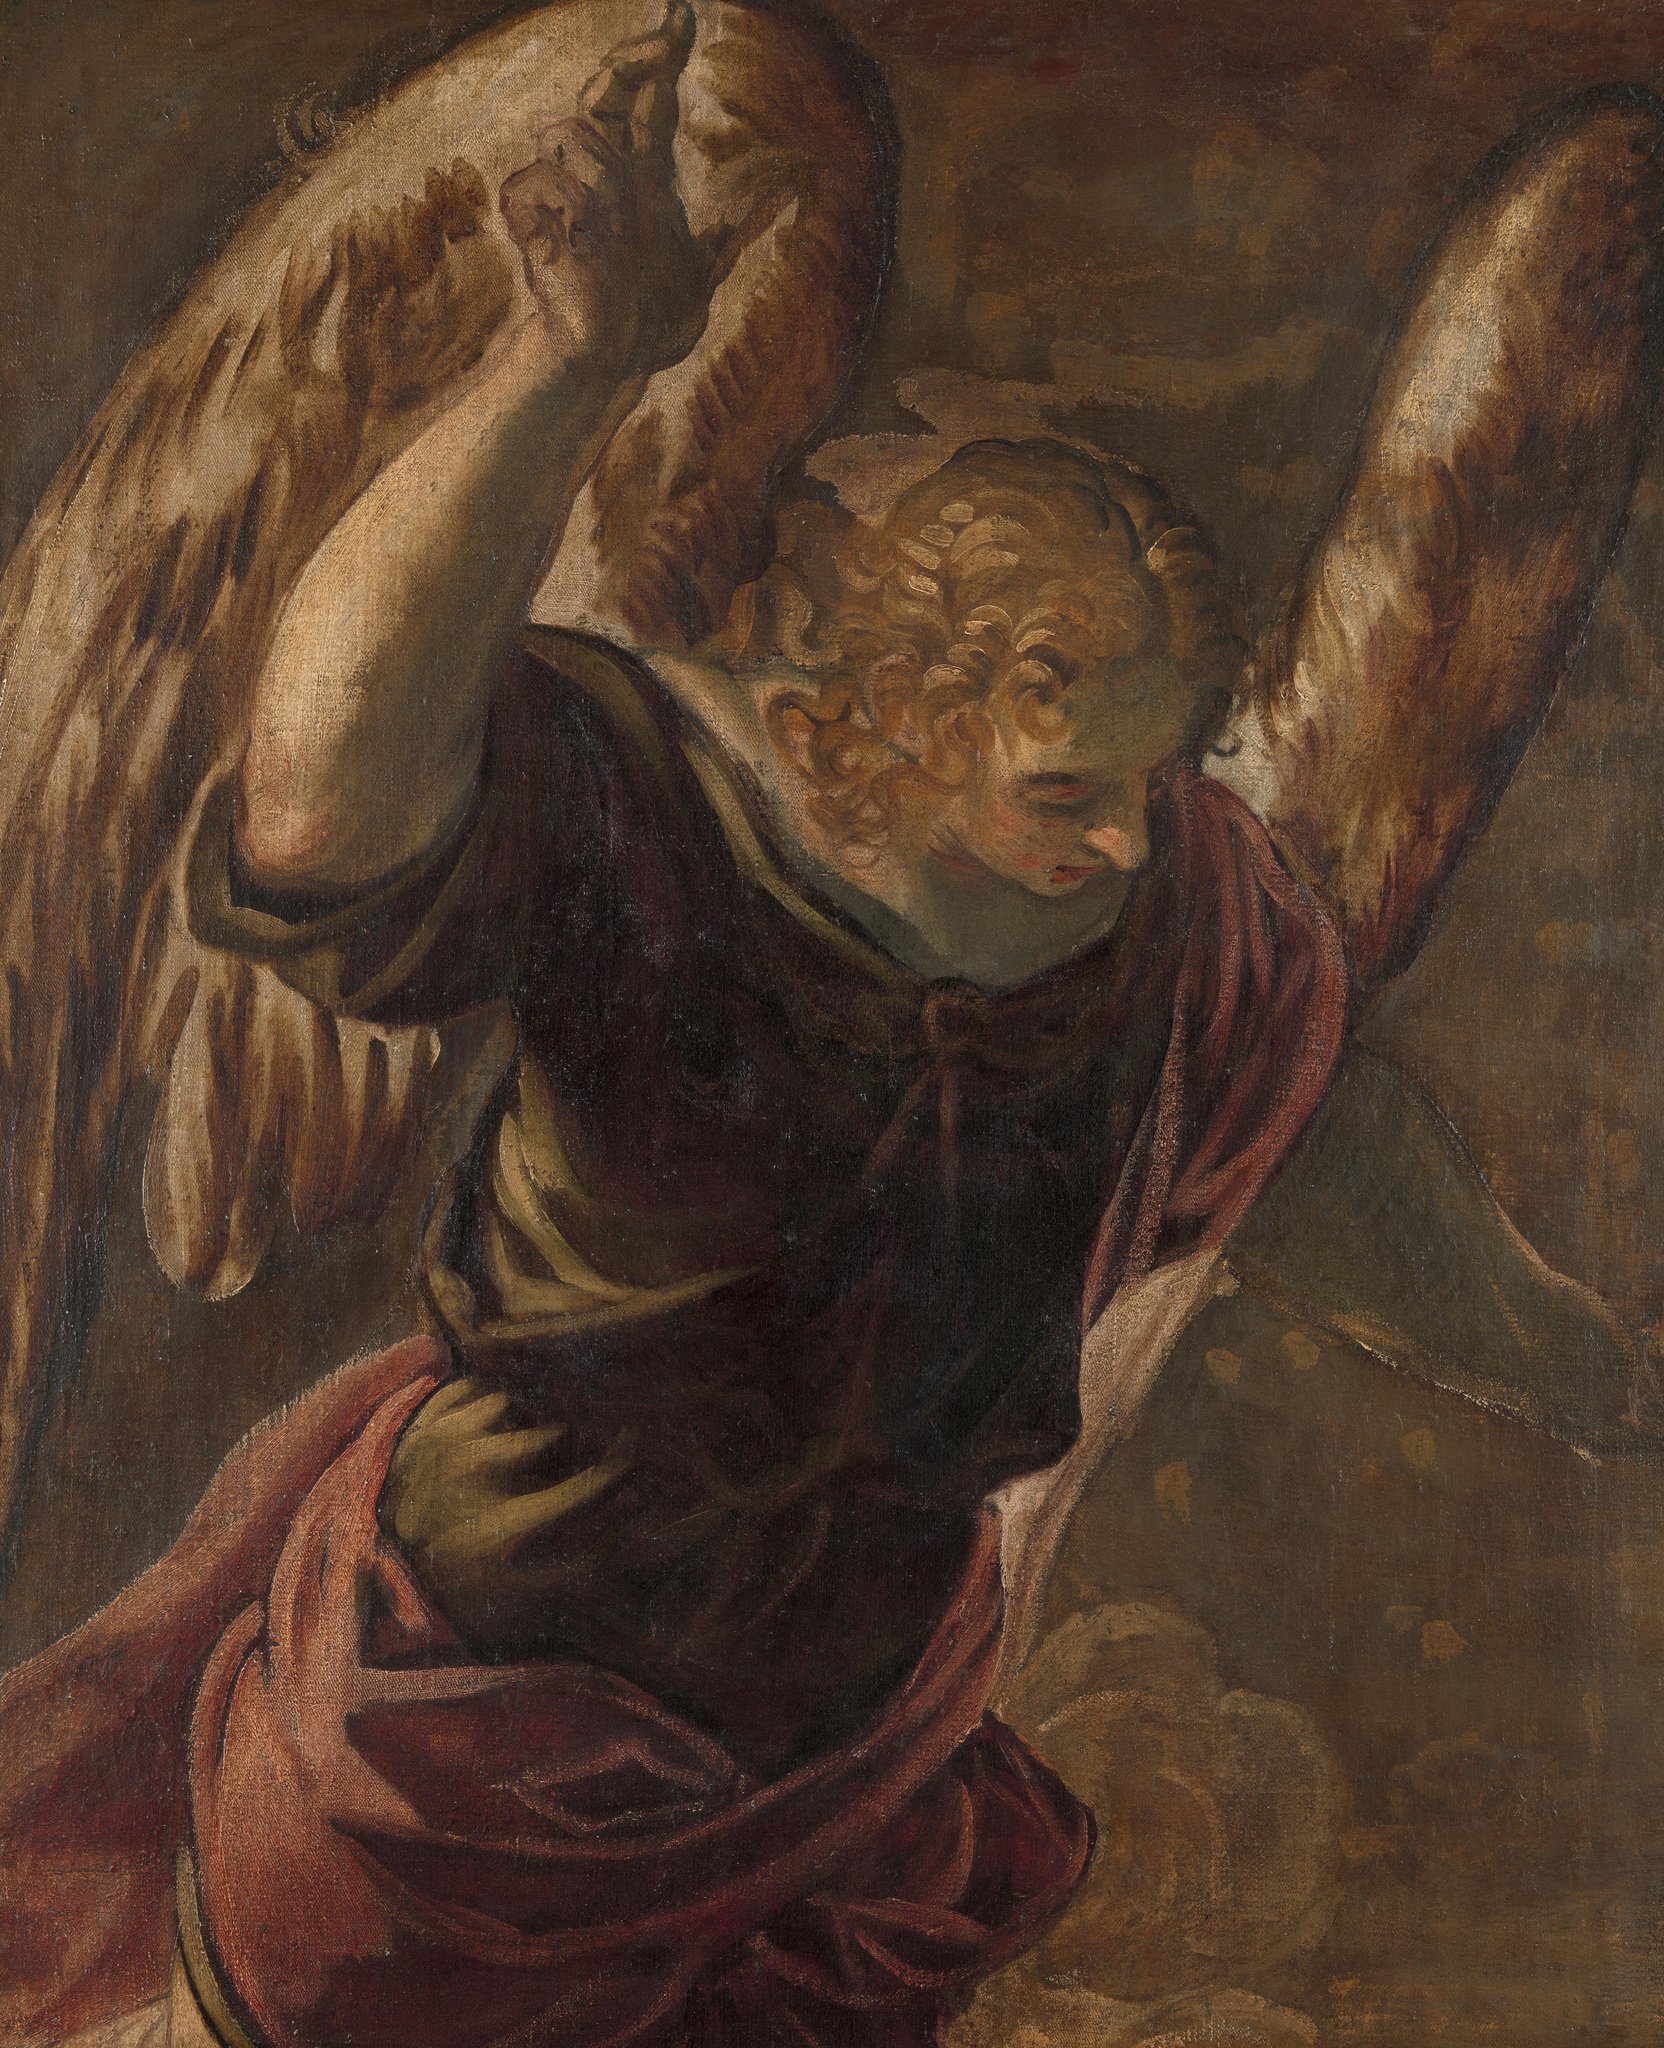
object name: fragment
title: Angel from the Annunciation to the Virgin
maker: jacopo tintoretto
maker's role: draughtsman, painter, print maker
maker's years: 1519-1594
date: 1560-1585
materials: canvas, oil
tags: the annunciation: mary, usually reading, is visited by the angel (sometimes a woman overhears the conversation)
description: Jacopo Tintoretto (1518 - 1594). The Archangel Gabriel, left half the Annunciation. Fragment of an organ-decoration, c. 1575. From the Otto Lanz collection, 1948.